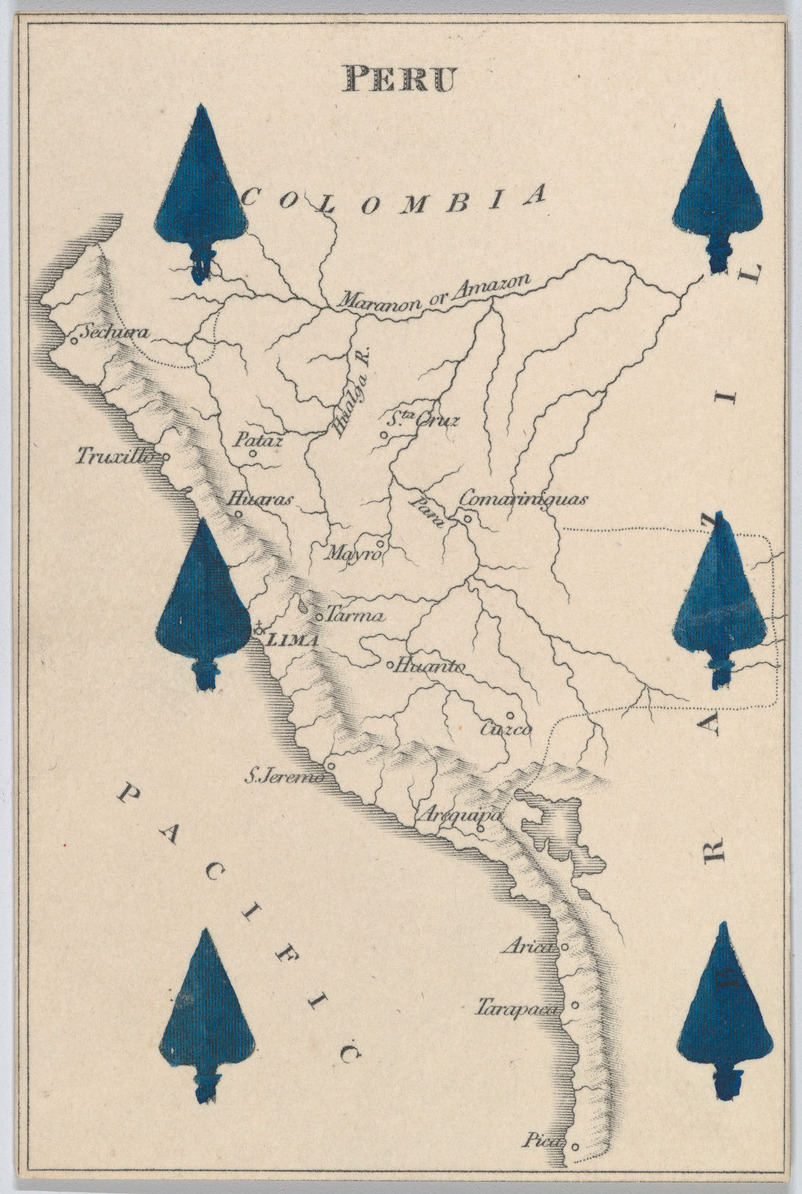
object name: print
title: Peru, from "Court Game of Geography"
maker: william and henry rock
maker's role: publisher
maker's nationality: british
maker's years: 1821-1884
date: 1838-1855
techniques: engraving, hand coloring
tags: playing cards,maps